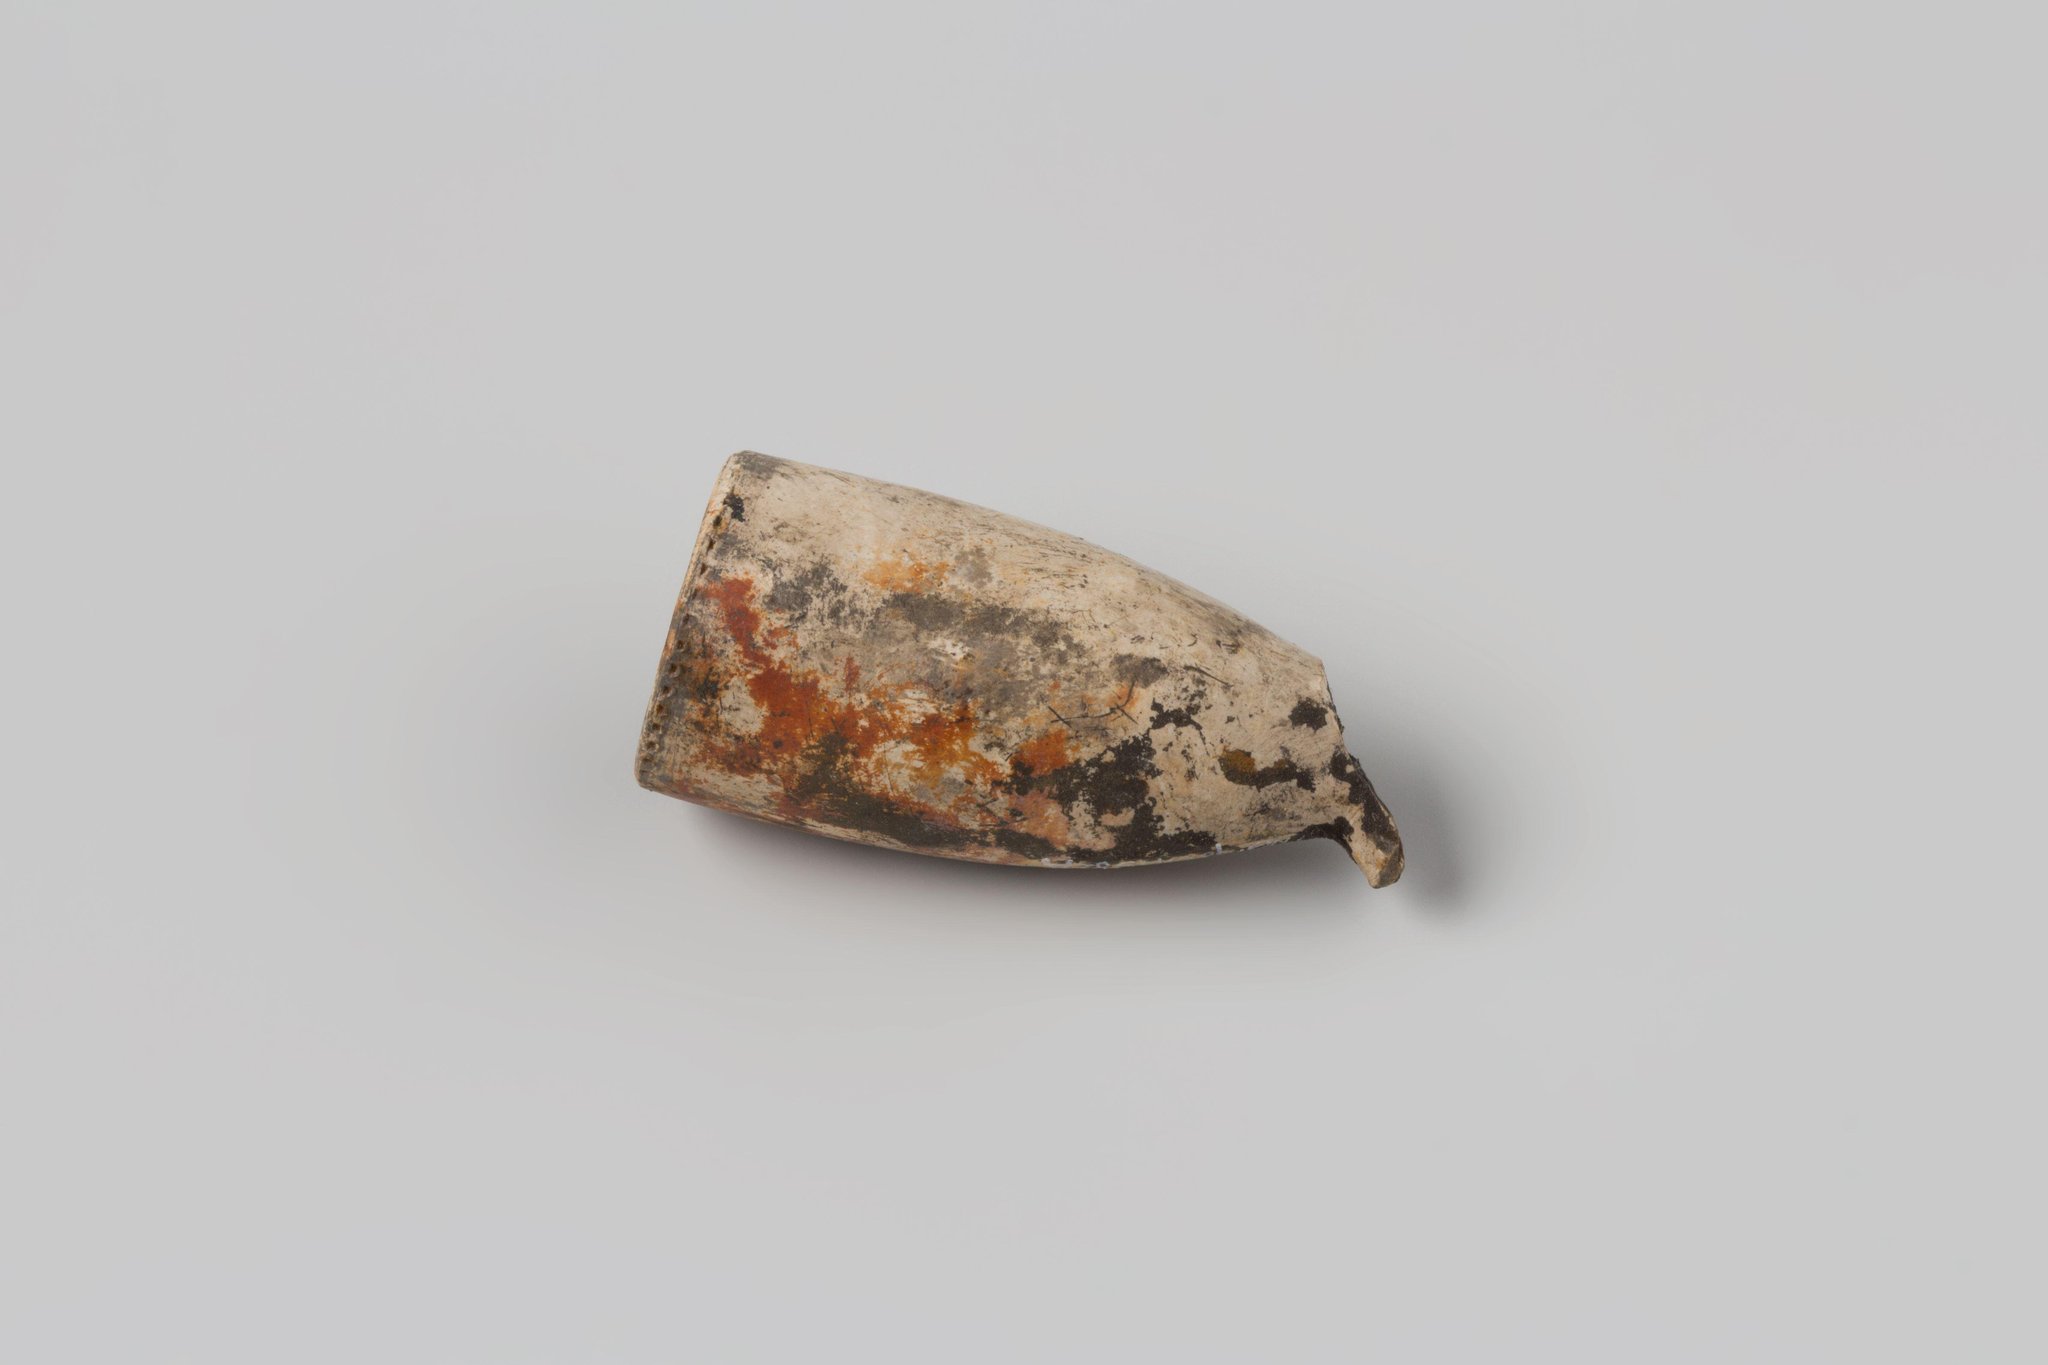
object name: pipe bowl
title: Pijpenkop uit het wrak van de Oost-Indiëvaarder Hollandia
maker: Anonymous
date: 1700-1743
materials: clay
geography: netherlands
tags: verenigde oostindische compagnie, hollandia (schip), annet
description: Pipe, bowl, heelmark illegible; fragment.